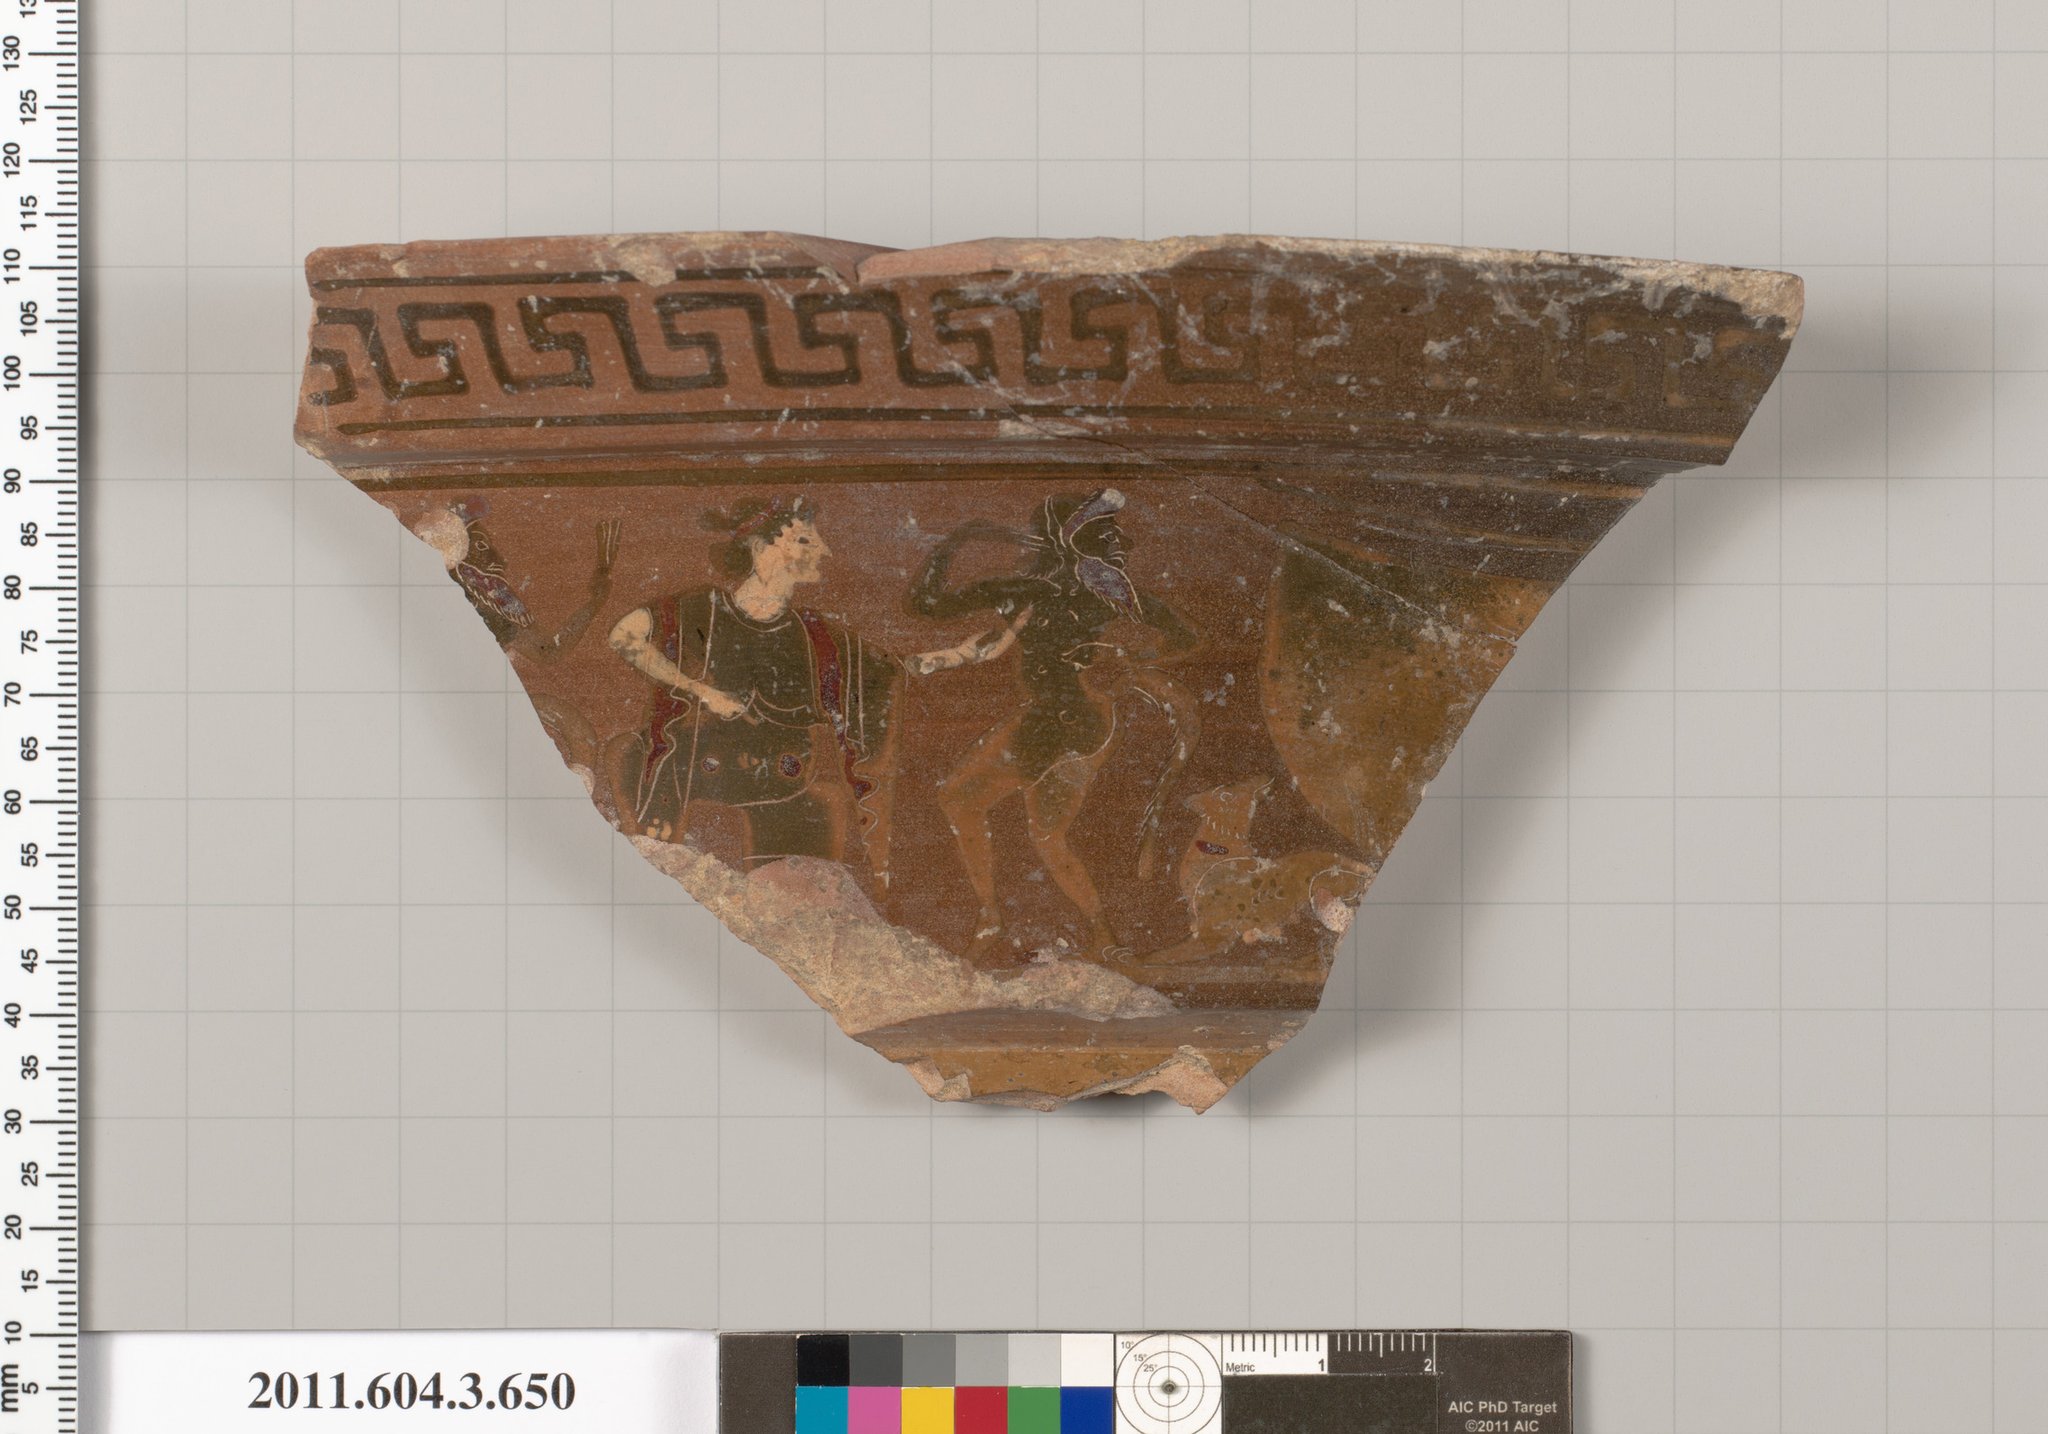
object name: volute krater fragment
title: Terracotta fragment of a volute-krater (bowl for mixing wine and water)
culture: greek, attic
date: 520-510 BCE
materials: terracotta